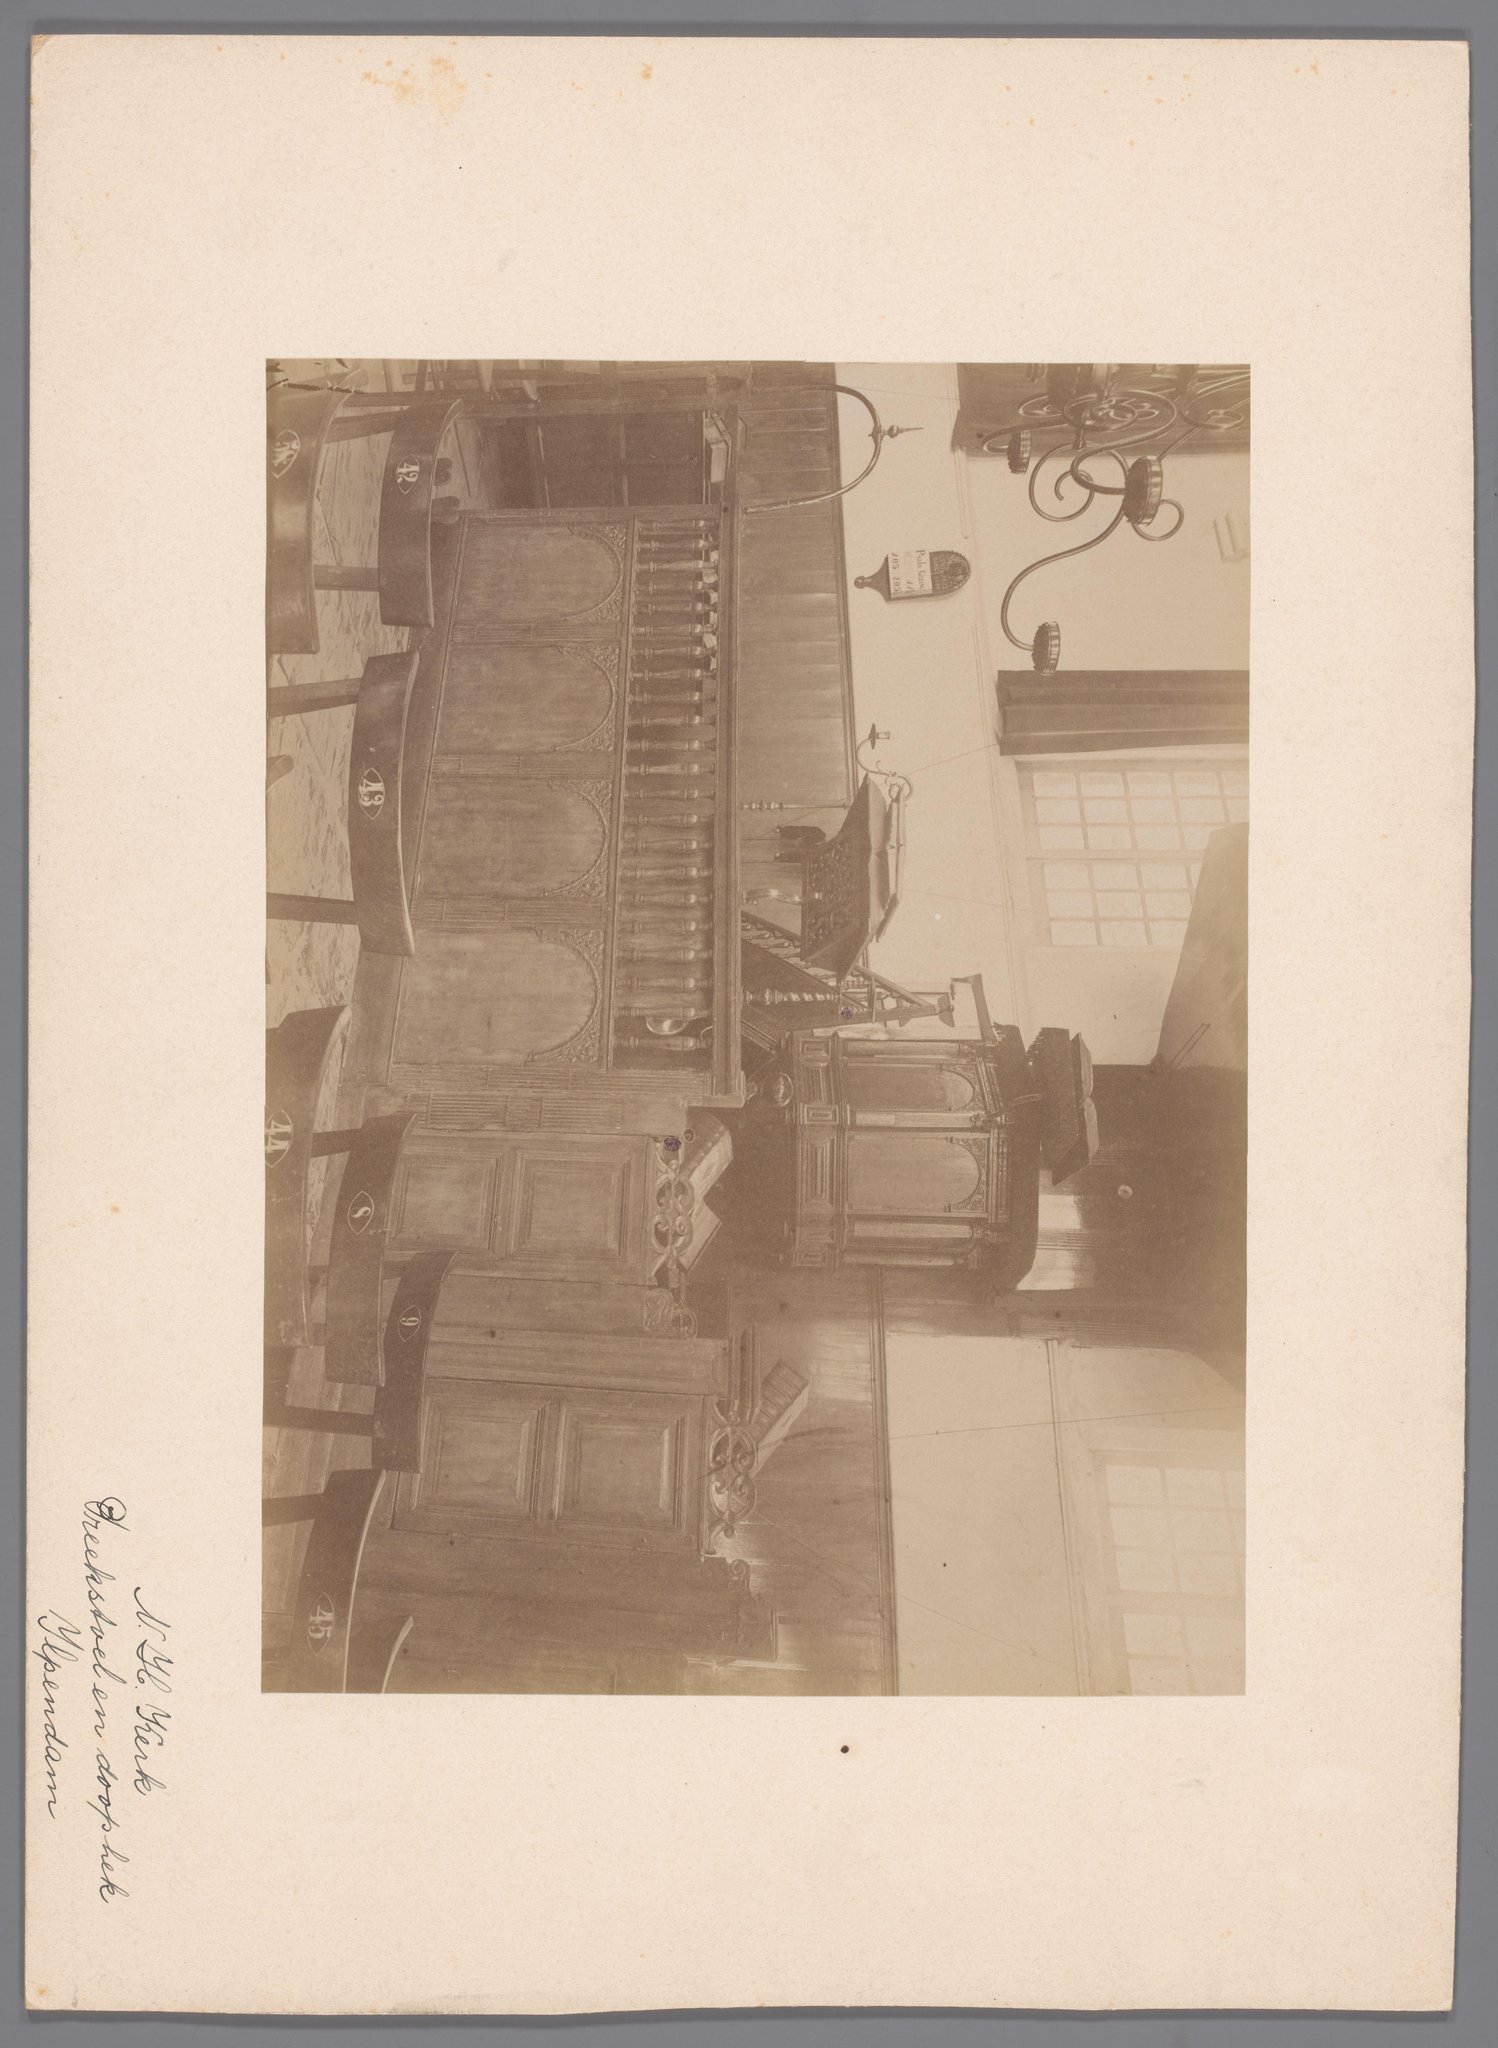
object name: photograph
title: Preekstoel en doophek in de Hervormde Kerk van Ilpendam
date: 1901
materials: cardboard, photographic support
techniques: albumen print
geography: dutch reformed church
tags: parts of church interior, interior of church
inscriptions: annotation: ‘Ilpendam (N.H.)/ preekstoel en doophek/ N.H. Kerk/ Mei 1901’, annotation: ‘N.H. Kerk/ Preekstoel en doophek/ Ilpendam’